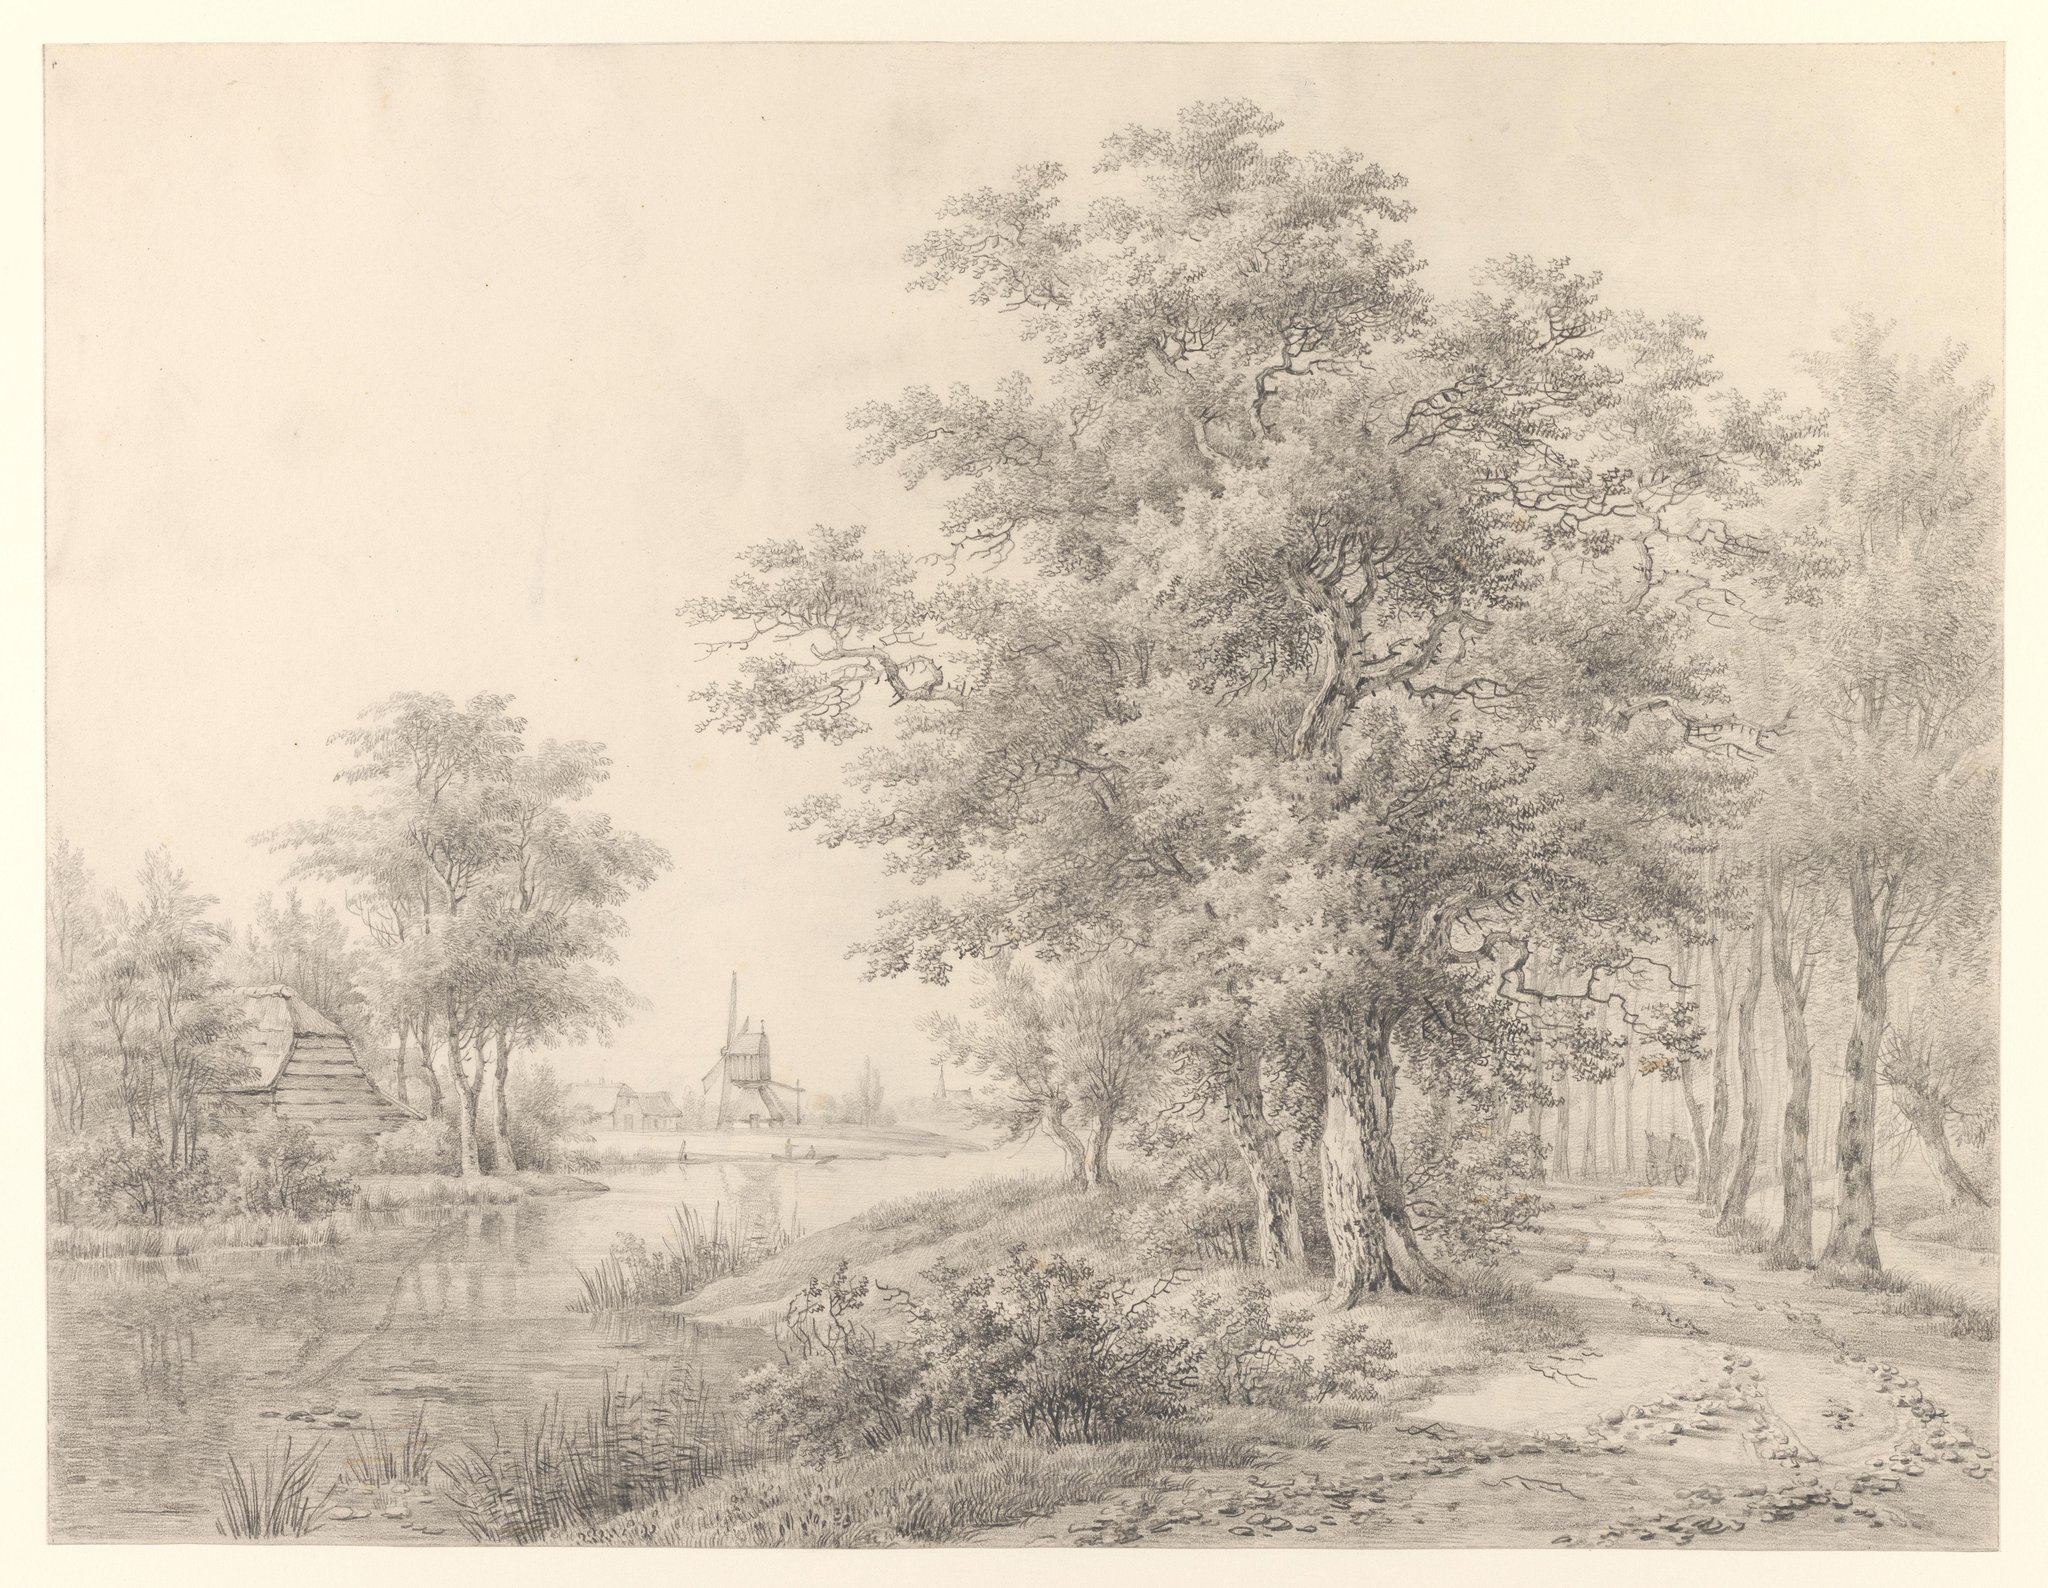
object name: drawing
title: Landschap met een rivier en een landweg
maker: willem de klerk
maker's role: draughtsman, painter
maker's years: 1800-1876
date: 1810-1876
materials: chalk, paper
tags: factories and mills in landscape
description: Landschap met links een rivier en in het verschiet een molen, rechts een landweg met een wagen.